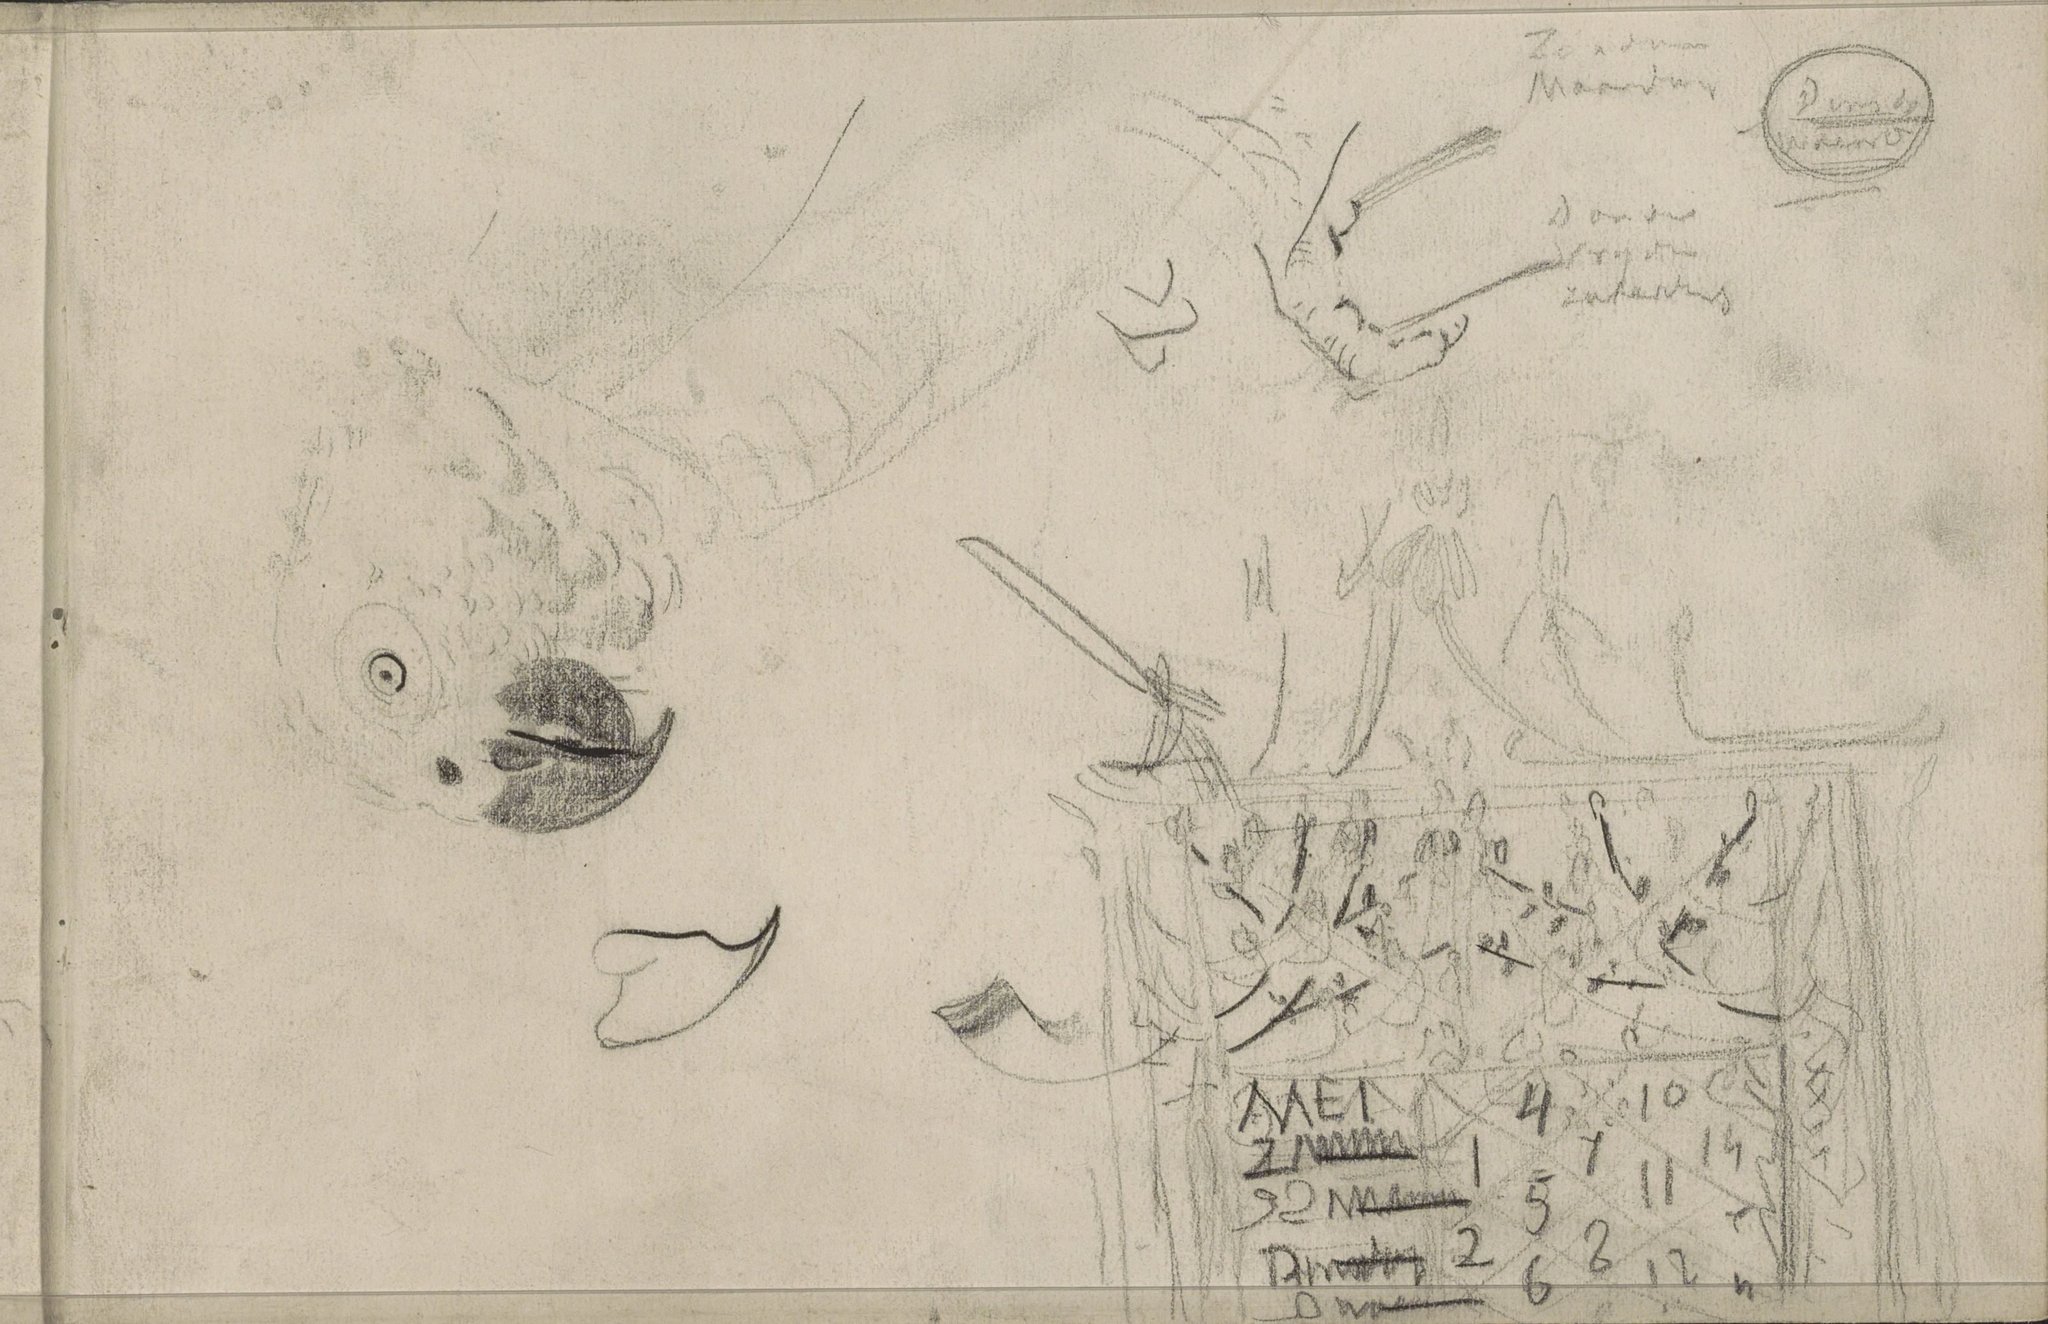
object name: sketchbook leaf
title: Kop van een papegaai en een ontwerp voor een maandkalender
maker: carel adolph lion cachet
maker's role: draughtsman, print maker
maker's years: 1864-1945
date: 1895-1900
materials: chalk, paper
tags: calendar, almanac, ornamental birds: parrot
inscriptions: annotation: ‘ZONDAG/ MAANDAG/ DINSDAG/ WOENSDAG/ DONDERDAG/ VRIJDAG/ ZATERDAG/ MEI’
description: Mogelijk een voorstudie voor een kalenderblad voor de maand mei uitgevoerd als litho (zie documentatie).